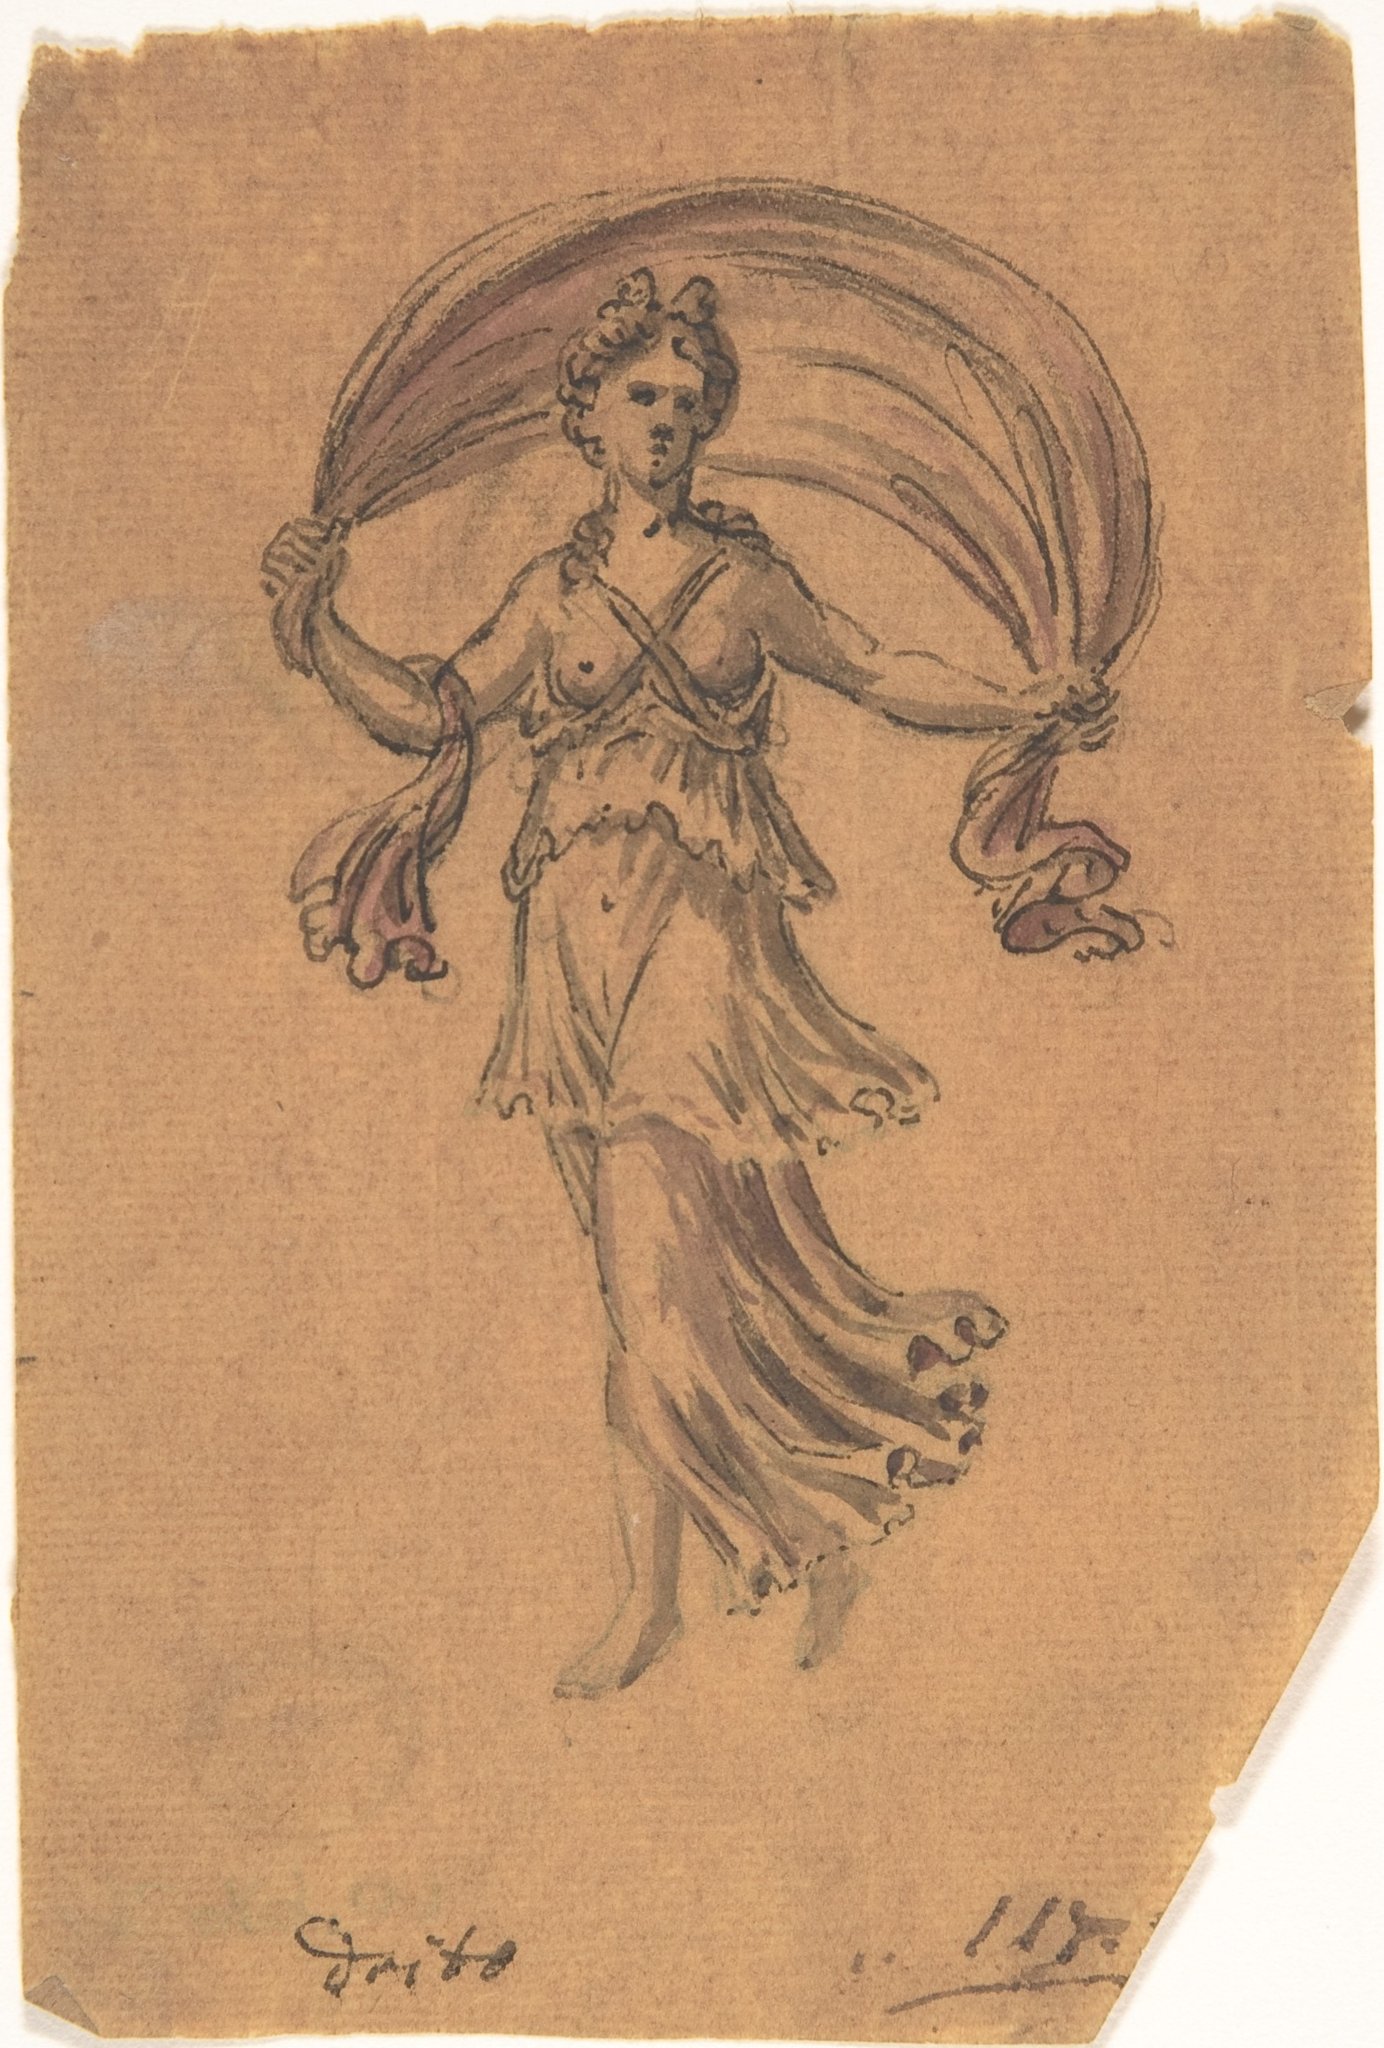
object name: drawing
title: Study of a Classical Female Figure (Night)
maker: anonymous, german, 19th century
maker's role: artist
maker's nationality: german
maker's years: 1800-1899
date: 1801-1900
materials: chalk, ink, paper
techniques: brush, pen, wash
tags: women